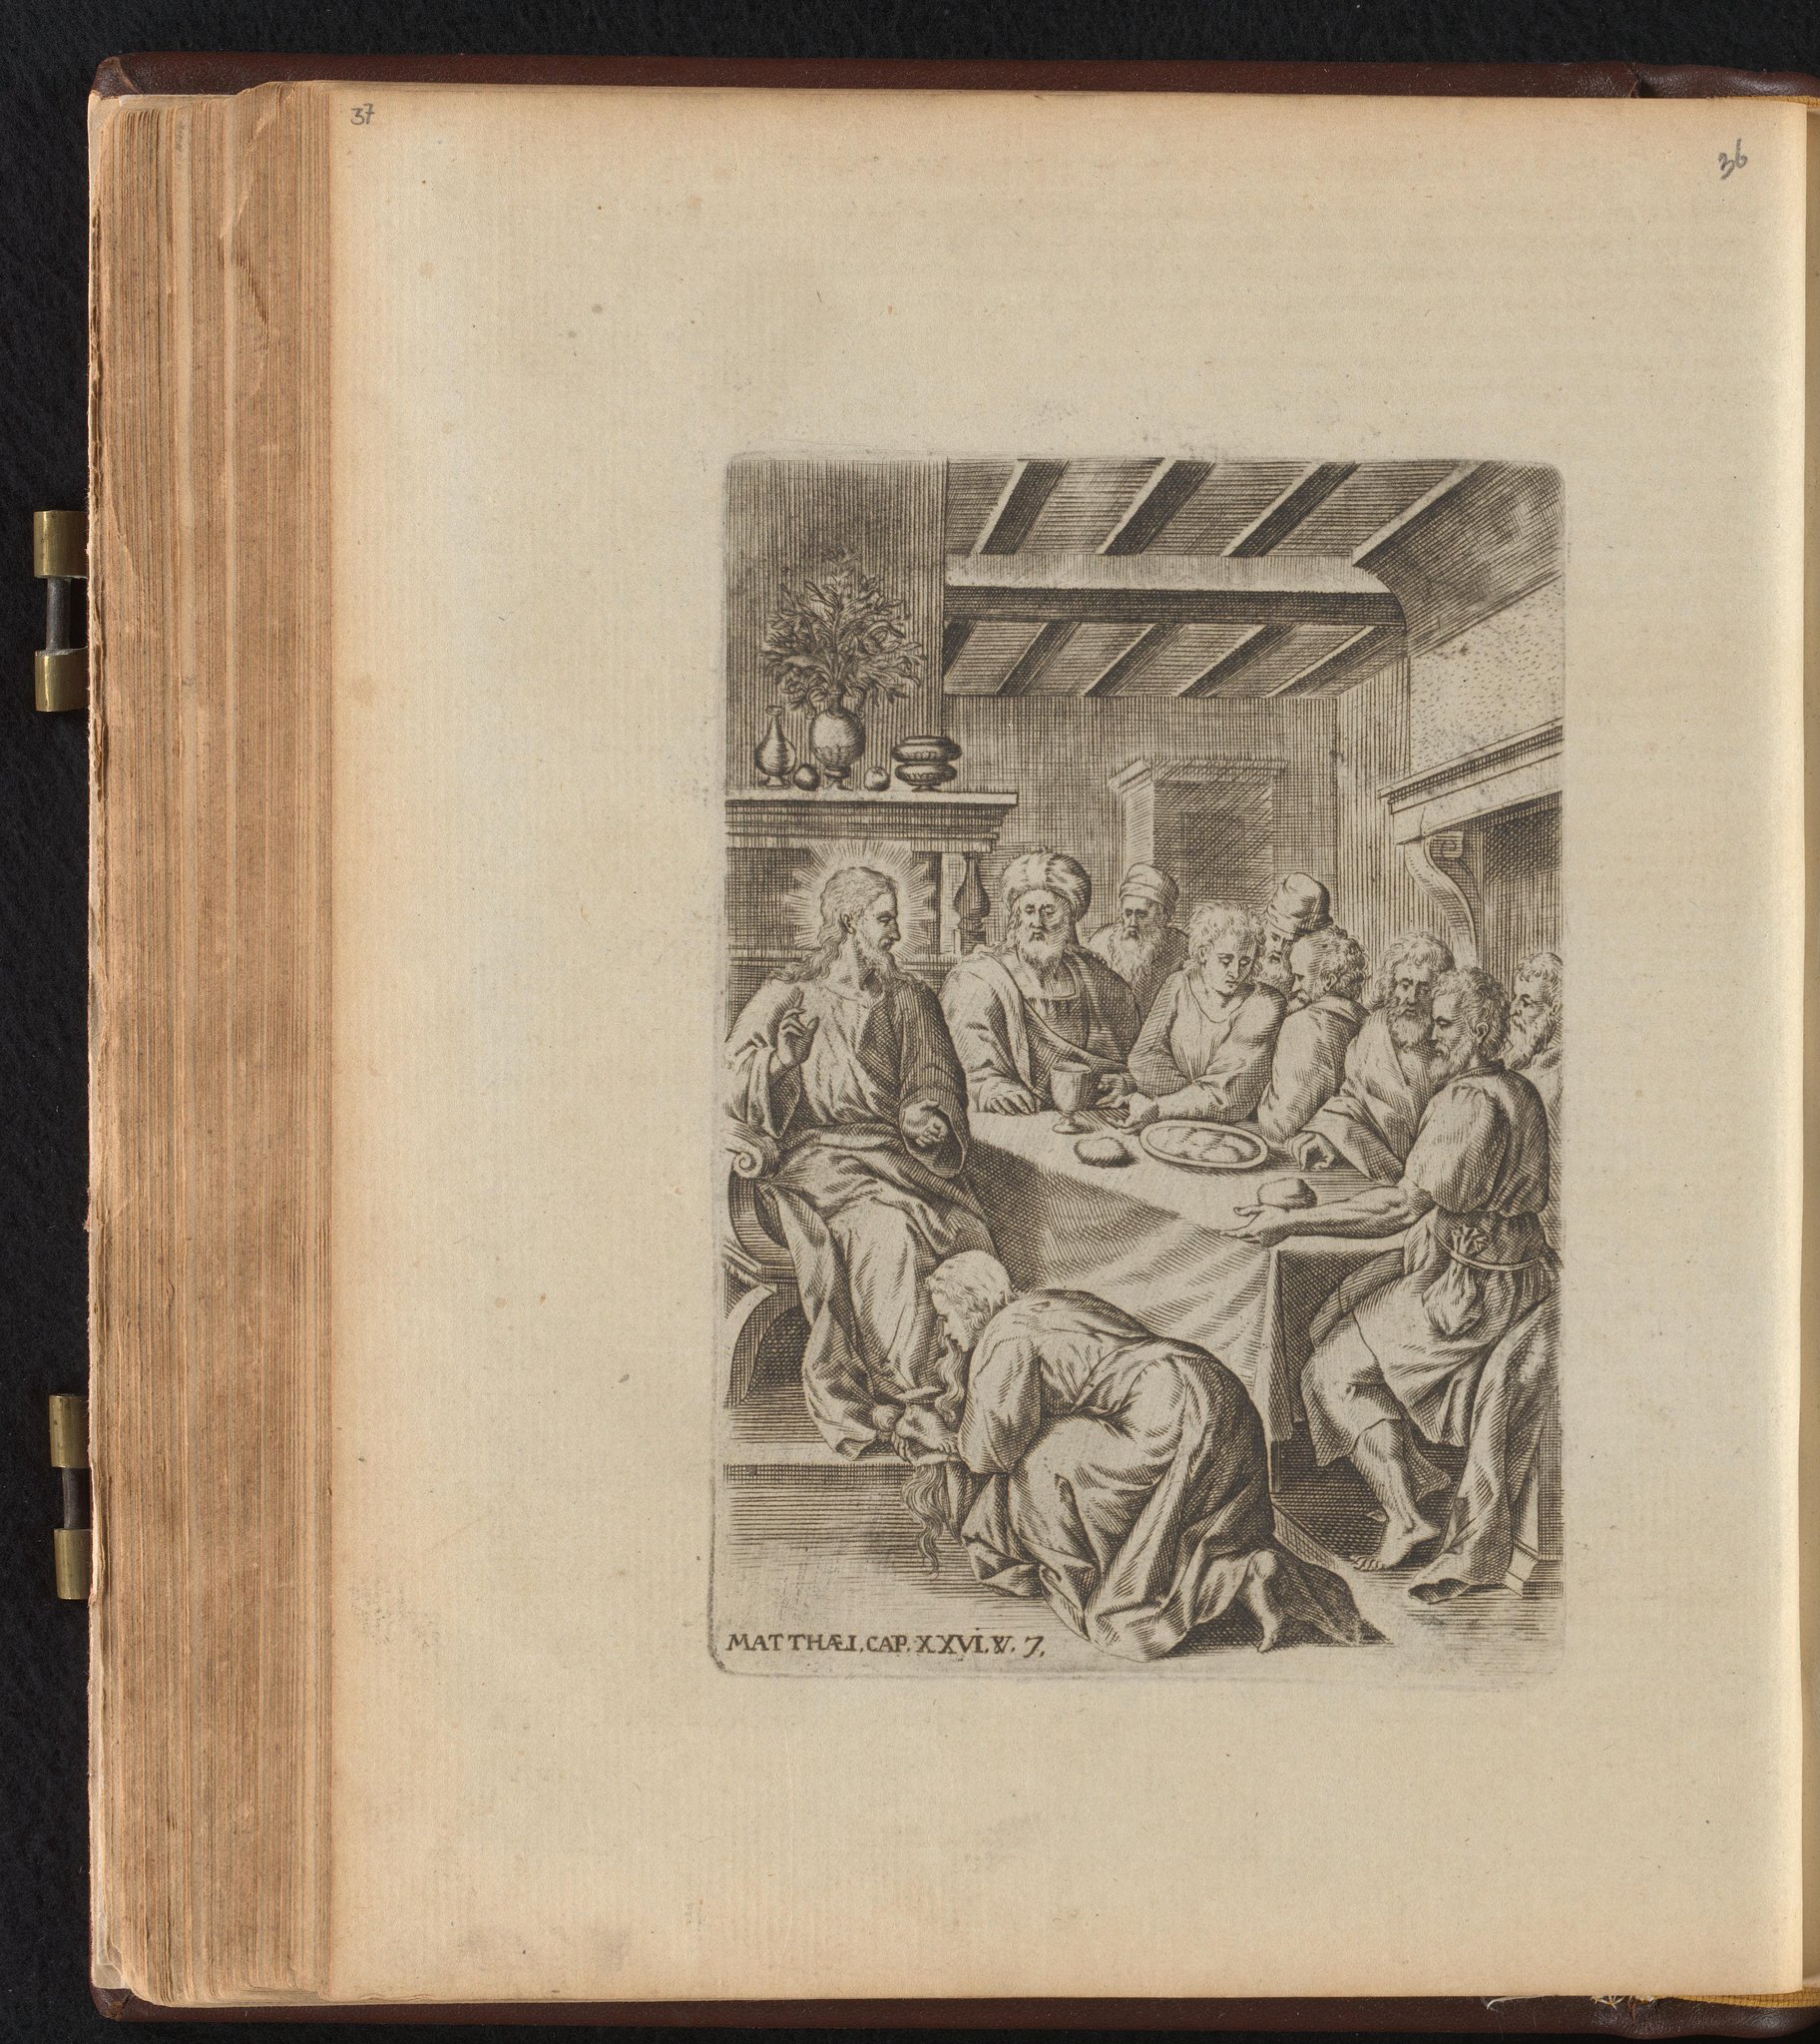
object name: album leaf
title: Christus in huis van Simon de Farizeeër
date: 1583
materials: paper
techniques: engraving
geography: antwerp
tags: a woman washes christ's feet with her tears, and wipes them with her hair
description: Eerdere staat van prent gebruikt als boekillustratie in: Biblia Sacra. Antwerpen: Christoffel Plantijn, 1583.